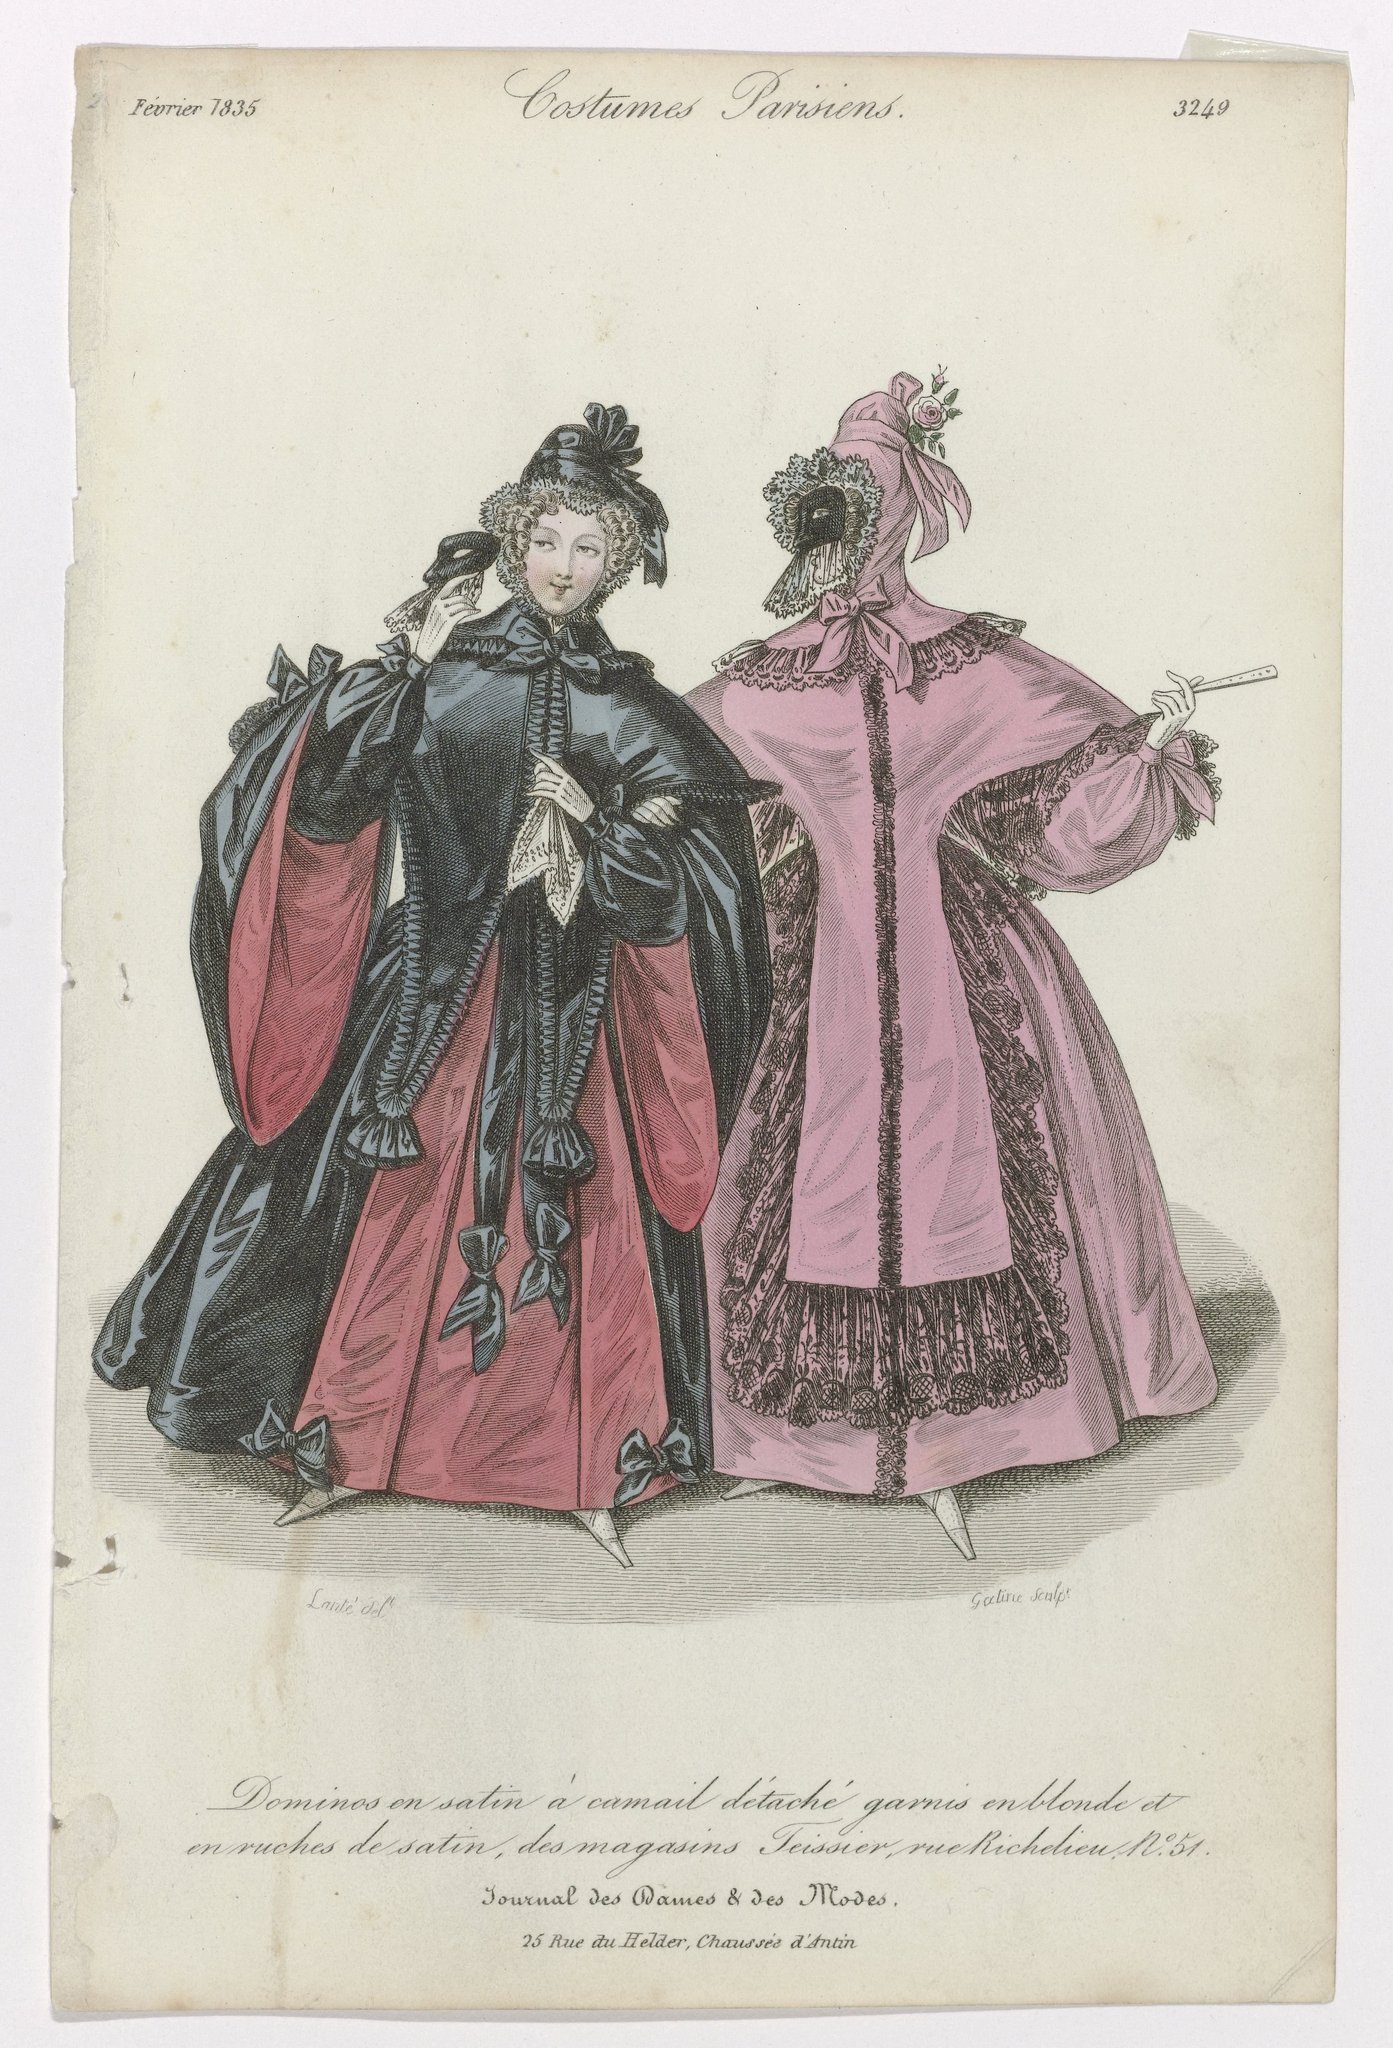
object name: fashion print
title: Journal des Dames et des Modes, Costumes Parisiens, fevrier 1835, (3249): Dominos en satin (...)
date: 1835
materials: paper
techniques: engraving, hand coloring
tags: clothing for the upper part of the body (+ women's clothes), handkerchief (+ women's clothes), mask (+ women's clothes), party clothes, festive attire (+ women's clothes), disguise (+ women's clothes), coat (domino) (+ women's clothes), head-gear (+ women's clothes), fashion plates, shoes, sandals (+ women's clothes), gloves, mittens, etc. (+ women's clothes), fan (+ women's clothes)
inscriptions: address: ‘Journal des Dames & des Modes. / 25 Rue du Helder, Chaussée d'Antin.’, caption: ‘Dominos en satin à camail détaché garnis en blonde et en ruches de satin, des magasins Teissier, rue Richelieu, No. 51.’, title: ‘Costumes Parisiens.’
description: Twee vrouwen gekleed in domino's van satijn met een losse 'camail' versierd met Blonde (kloskant) en ruches van satijn, uit de winkel van Teissier. Half masker, aan de onderkant afgezet met doorzichtige stof. Verdere accessoires: handschoenen, zakdoek, waaier, schoenen met vierkante neuzen. De prent maakt deel uit van het modetijdschrift Journal des Dames et des Modes, Parijs, 1797-1839.